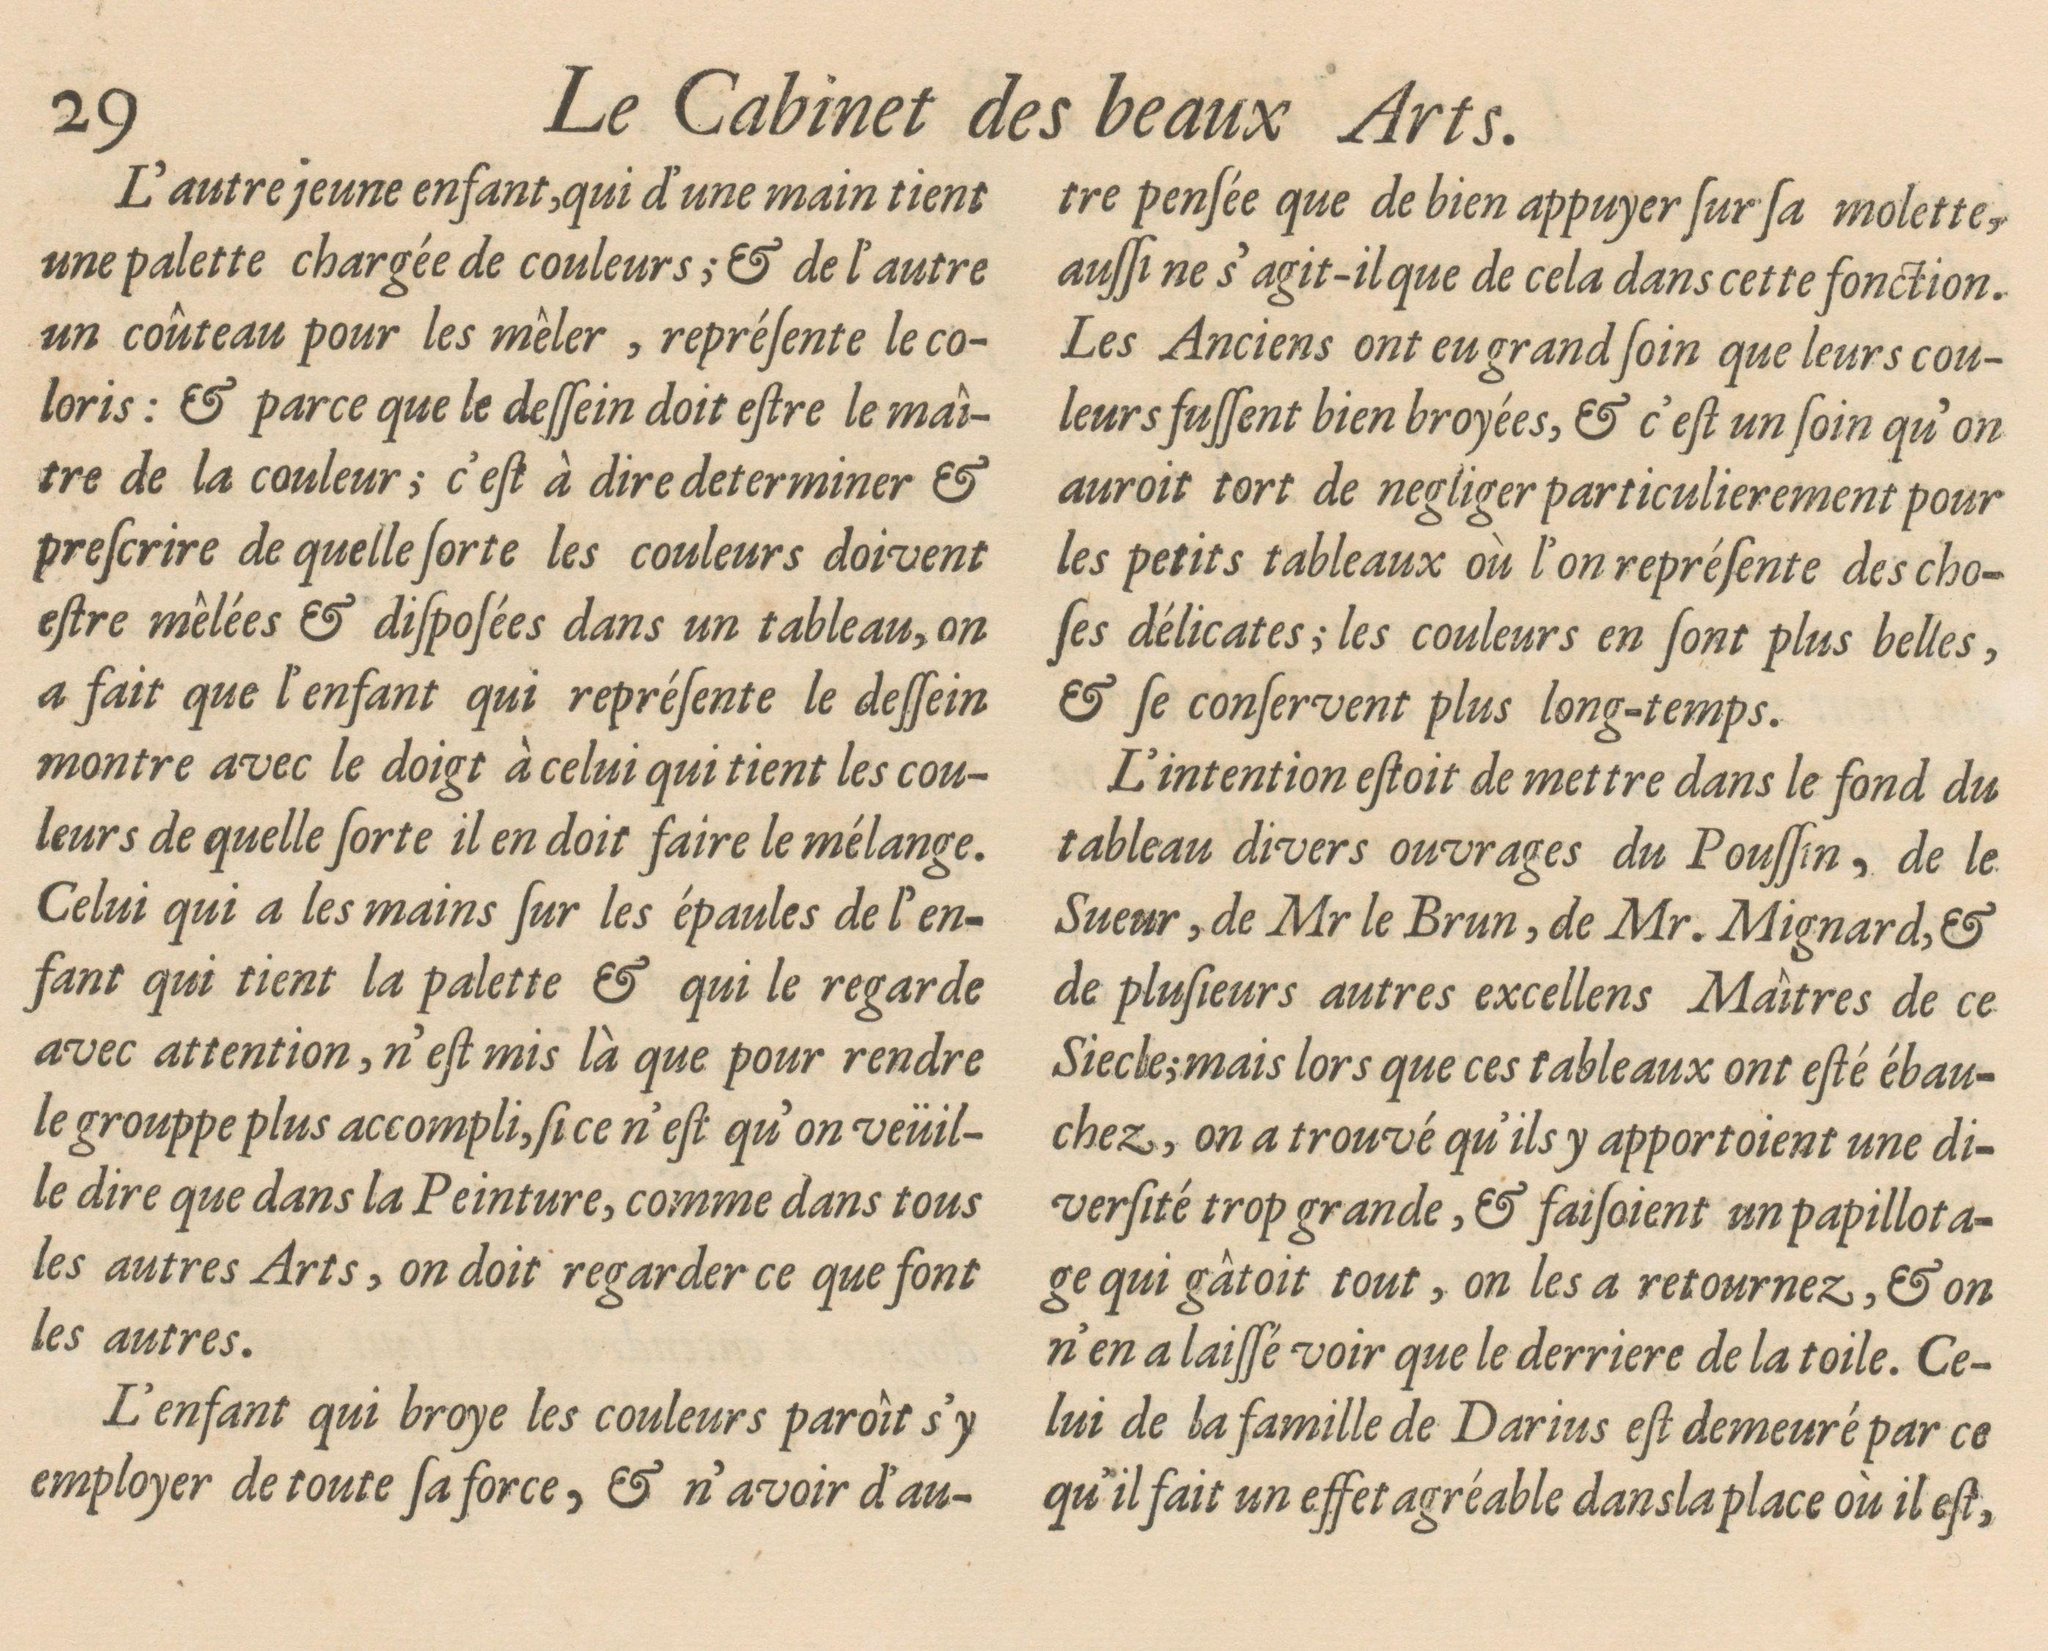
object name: text sheet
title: Tekstblad met verklaring van de prent over Schilderkunst, p. 29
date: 1695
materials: paper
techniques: letterpress printing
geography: paris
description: Verklaring van de prent met voorstelling van Schilderkunst in het Frans. Pagina 29. Tekstblad maakt deel uit van een album.